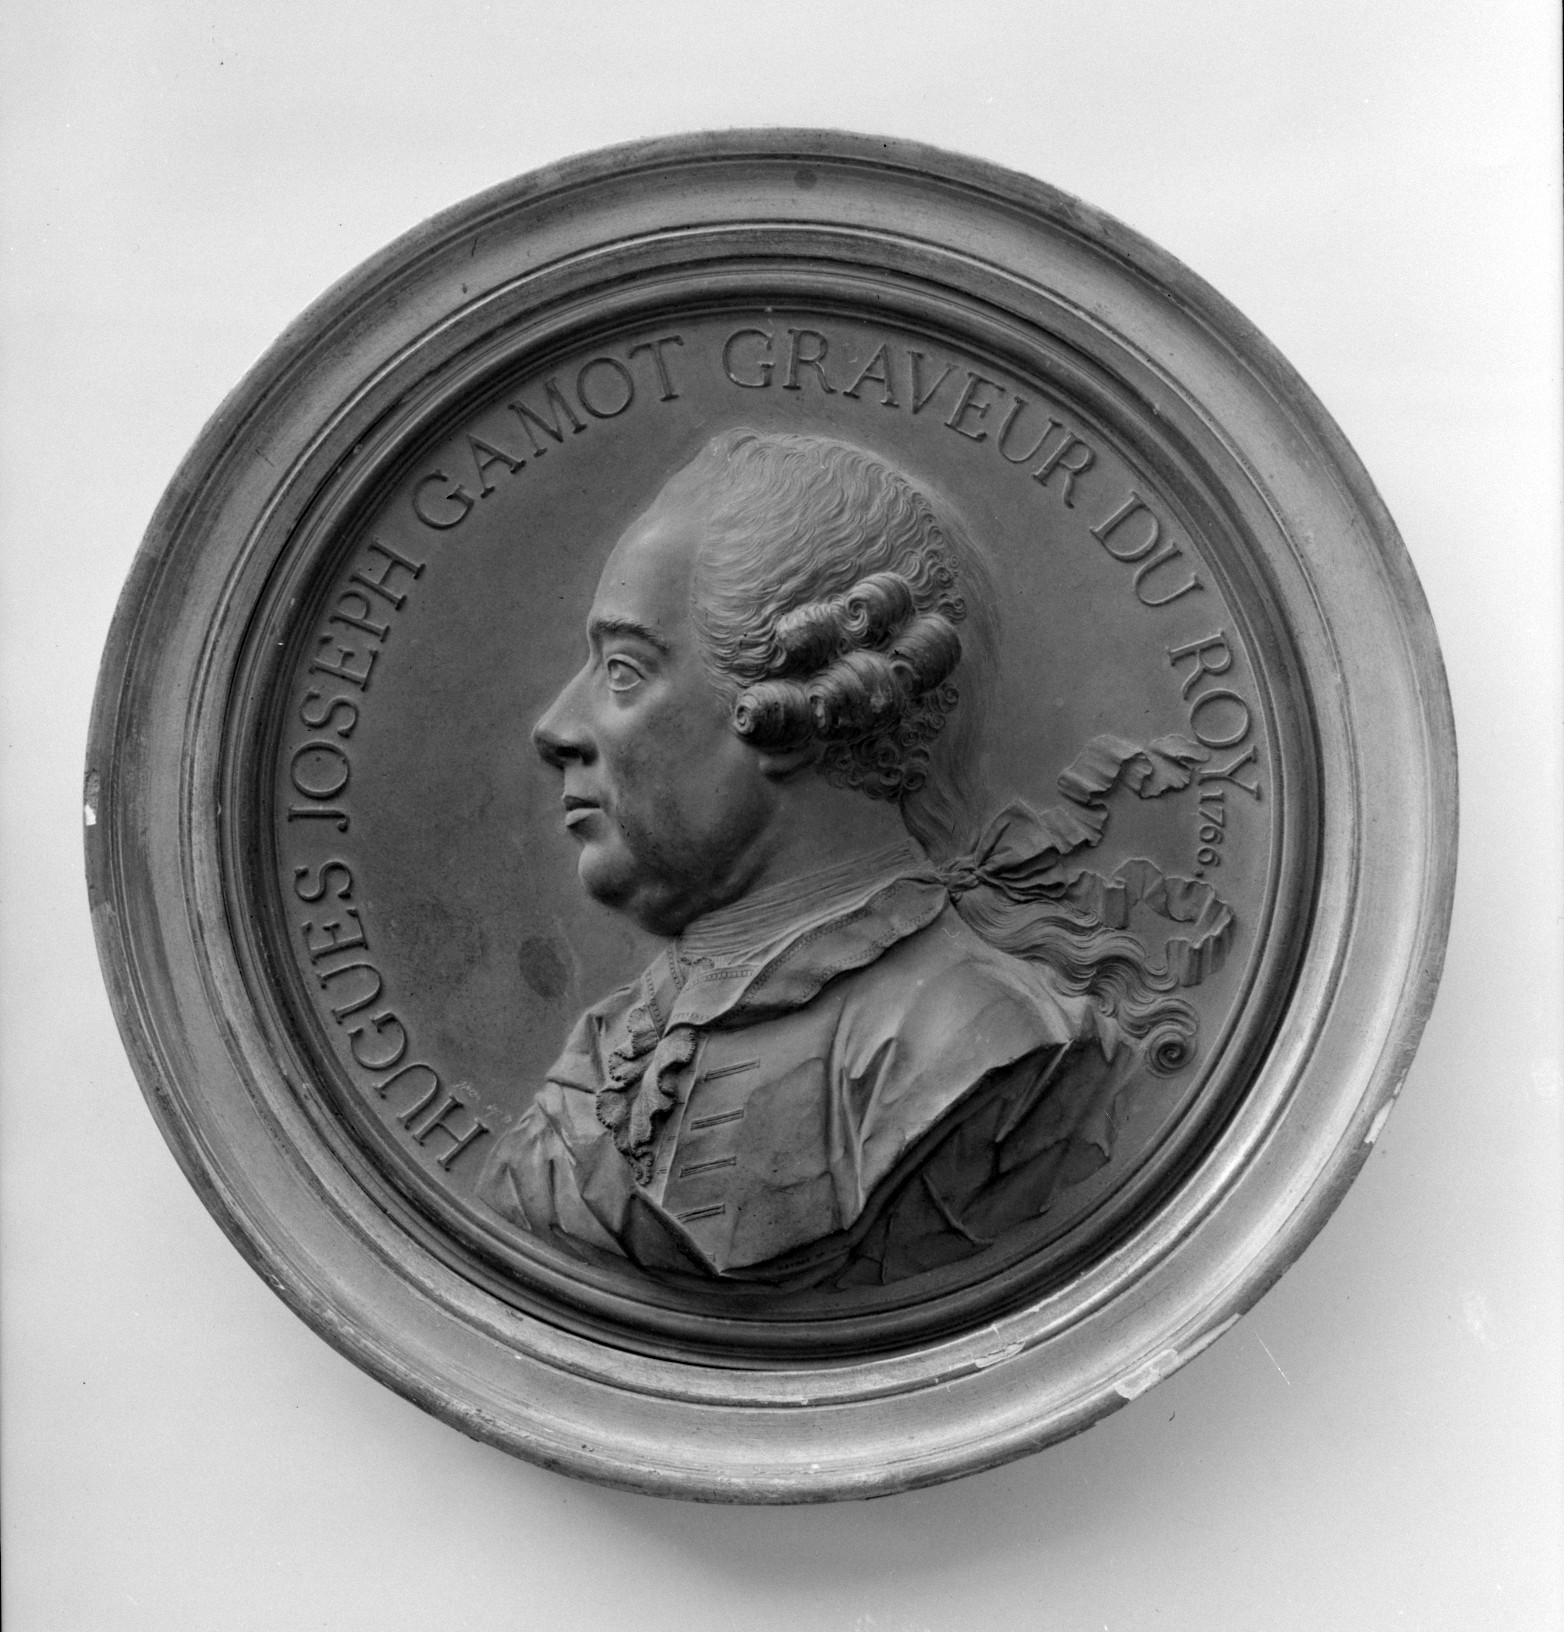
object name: medallion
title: Hugues-Joseph Gamot, Engraver to the King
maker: jean-baptiste nini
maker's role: artist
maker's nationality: italian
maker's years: 1717-1786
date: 1766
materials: gilt, terracotta, wood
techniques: casting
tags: men,profiles